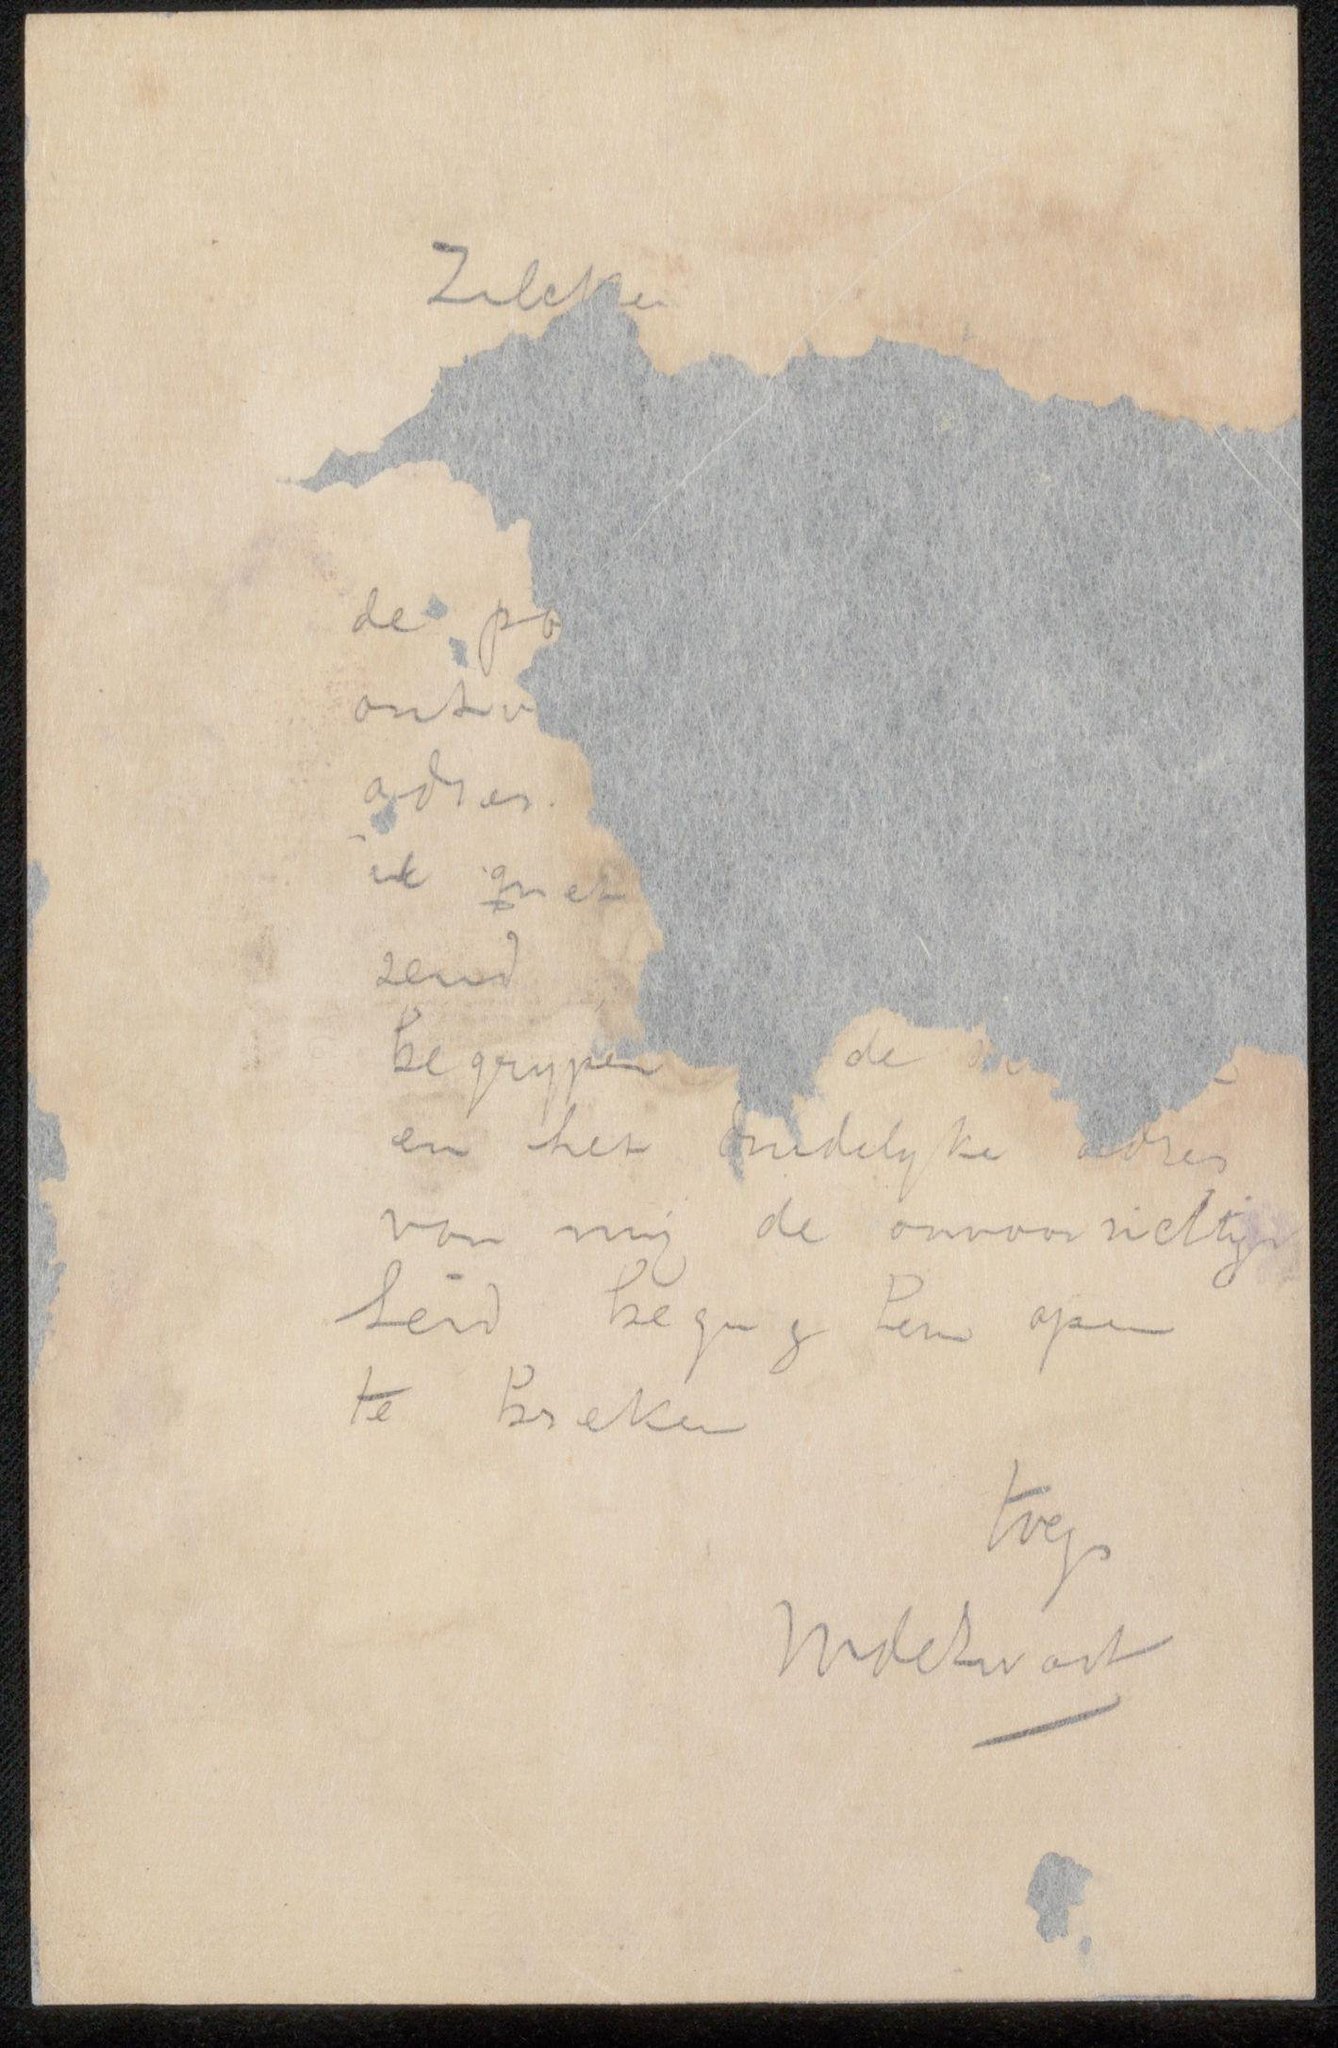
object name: letter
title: Brief aan Philip Zilcken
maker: willem de zwart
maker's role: draughtsman, painter, print maker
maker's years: 1862-1931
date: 1872-1930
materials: ink, paper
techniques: pen, writing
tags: the hague, painter, draughtsman, philip zilcken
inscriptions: collector's mark: ‘RPK’